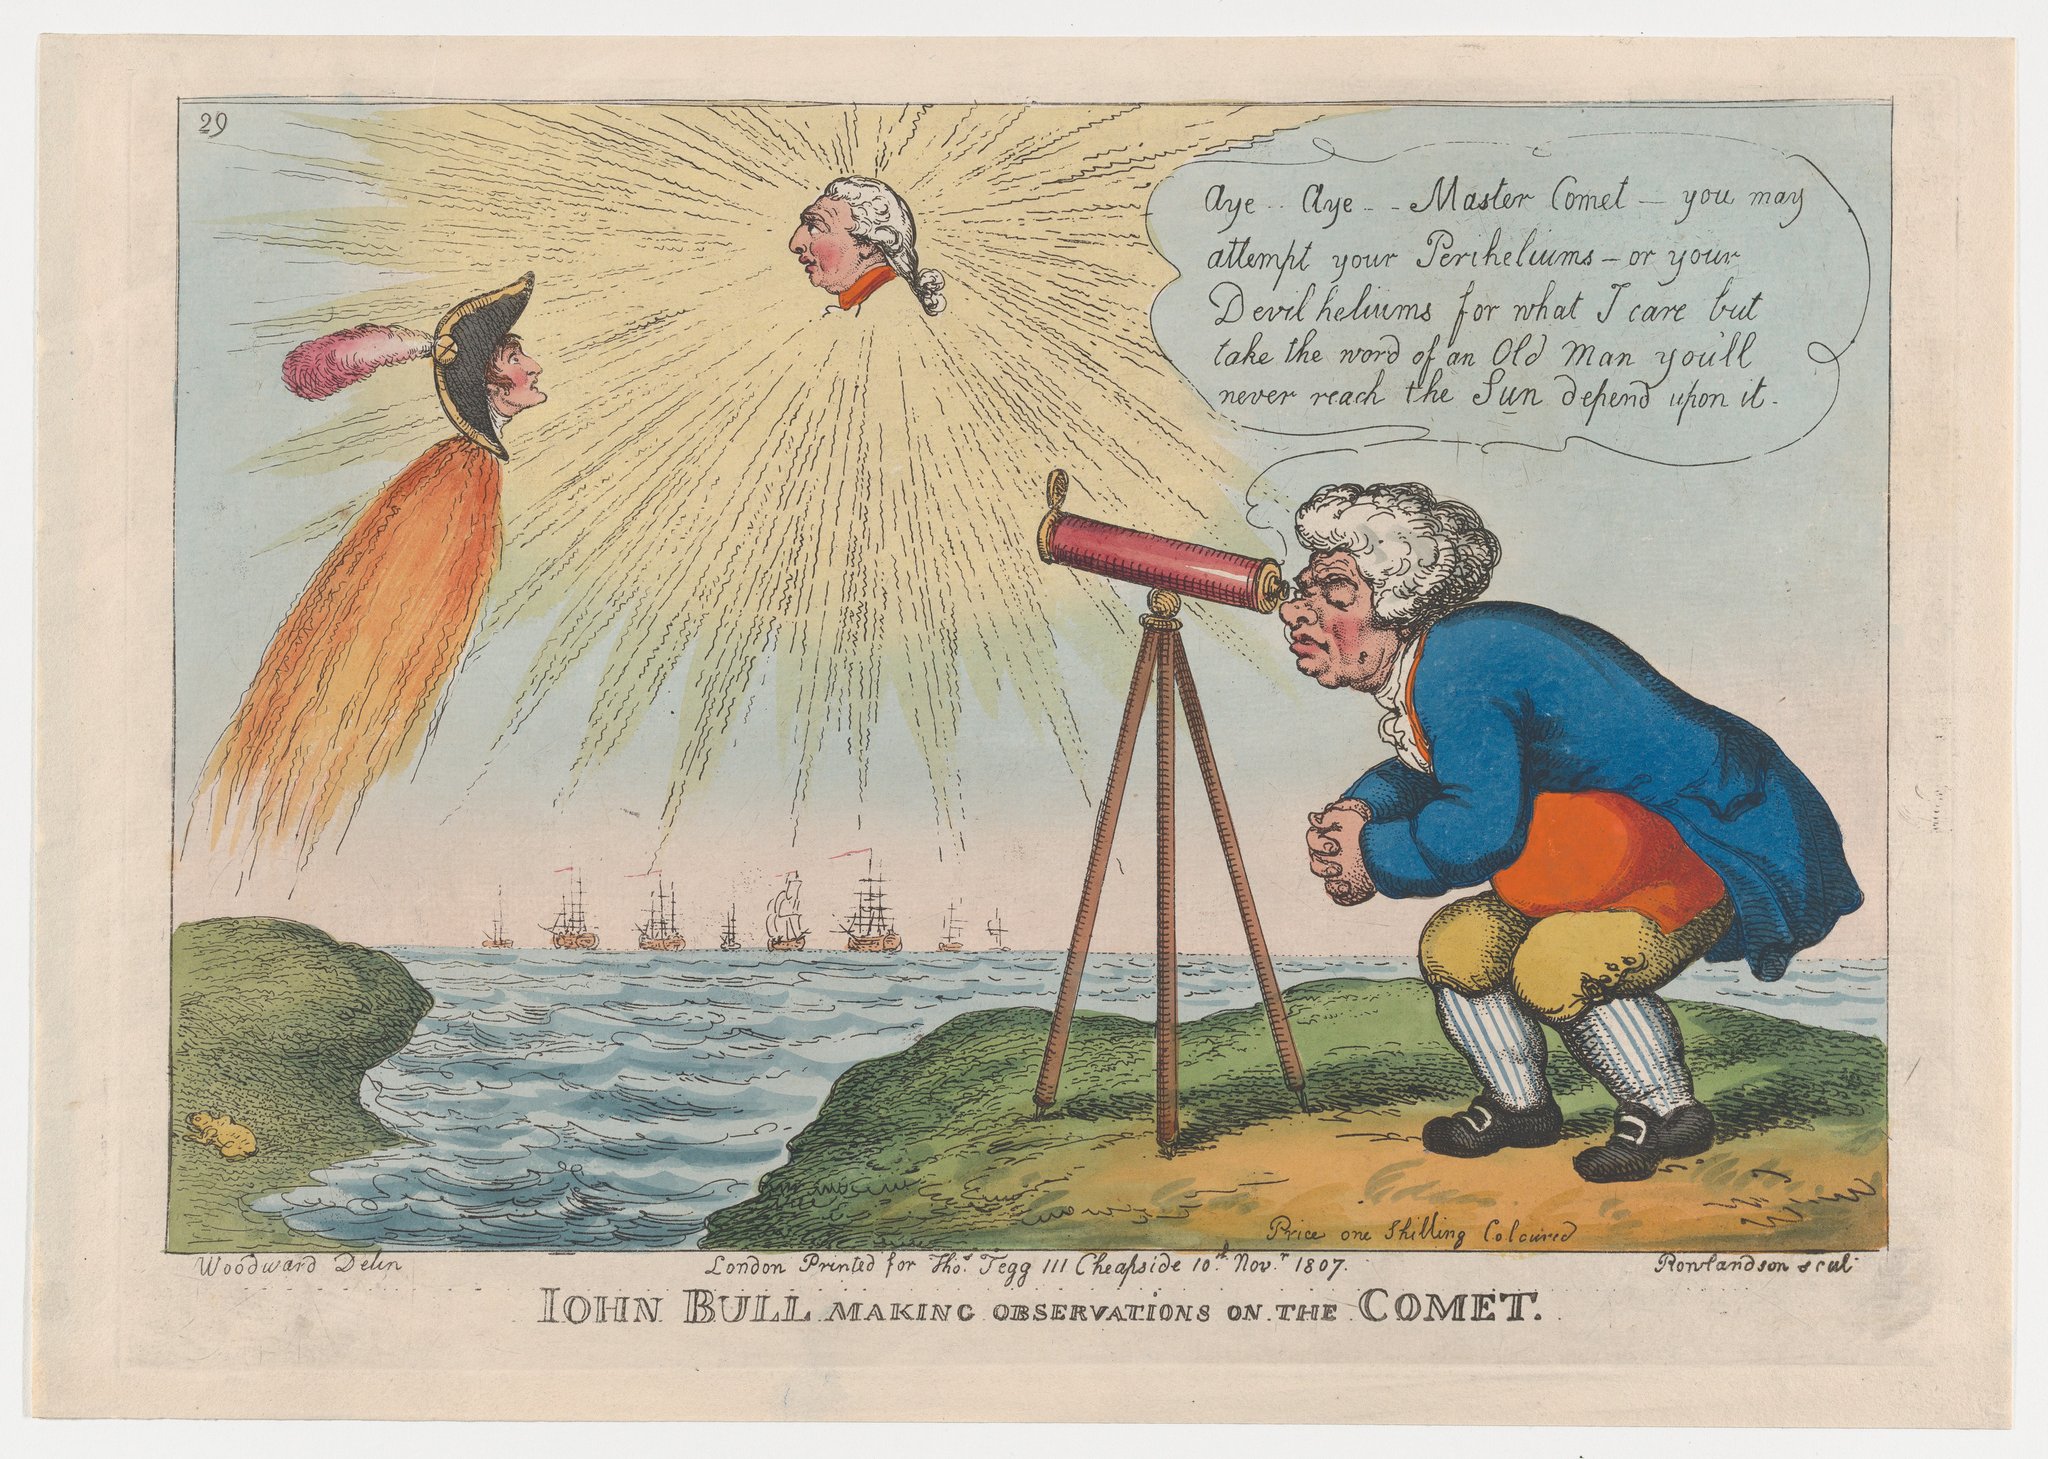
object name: print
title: John Bull Making Observations on the Comet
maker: thomas rowlandson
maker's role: artist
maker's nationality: british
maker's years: 1757-1827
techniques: etching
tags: satire,men,telescopes,politics